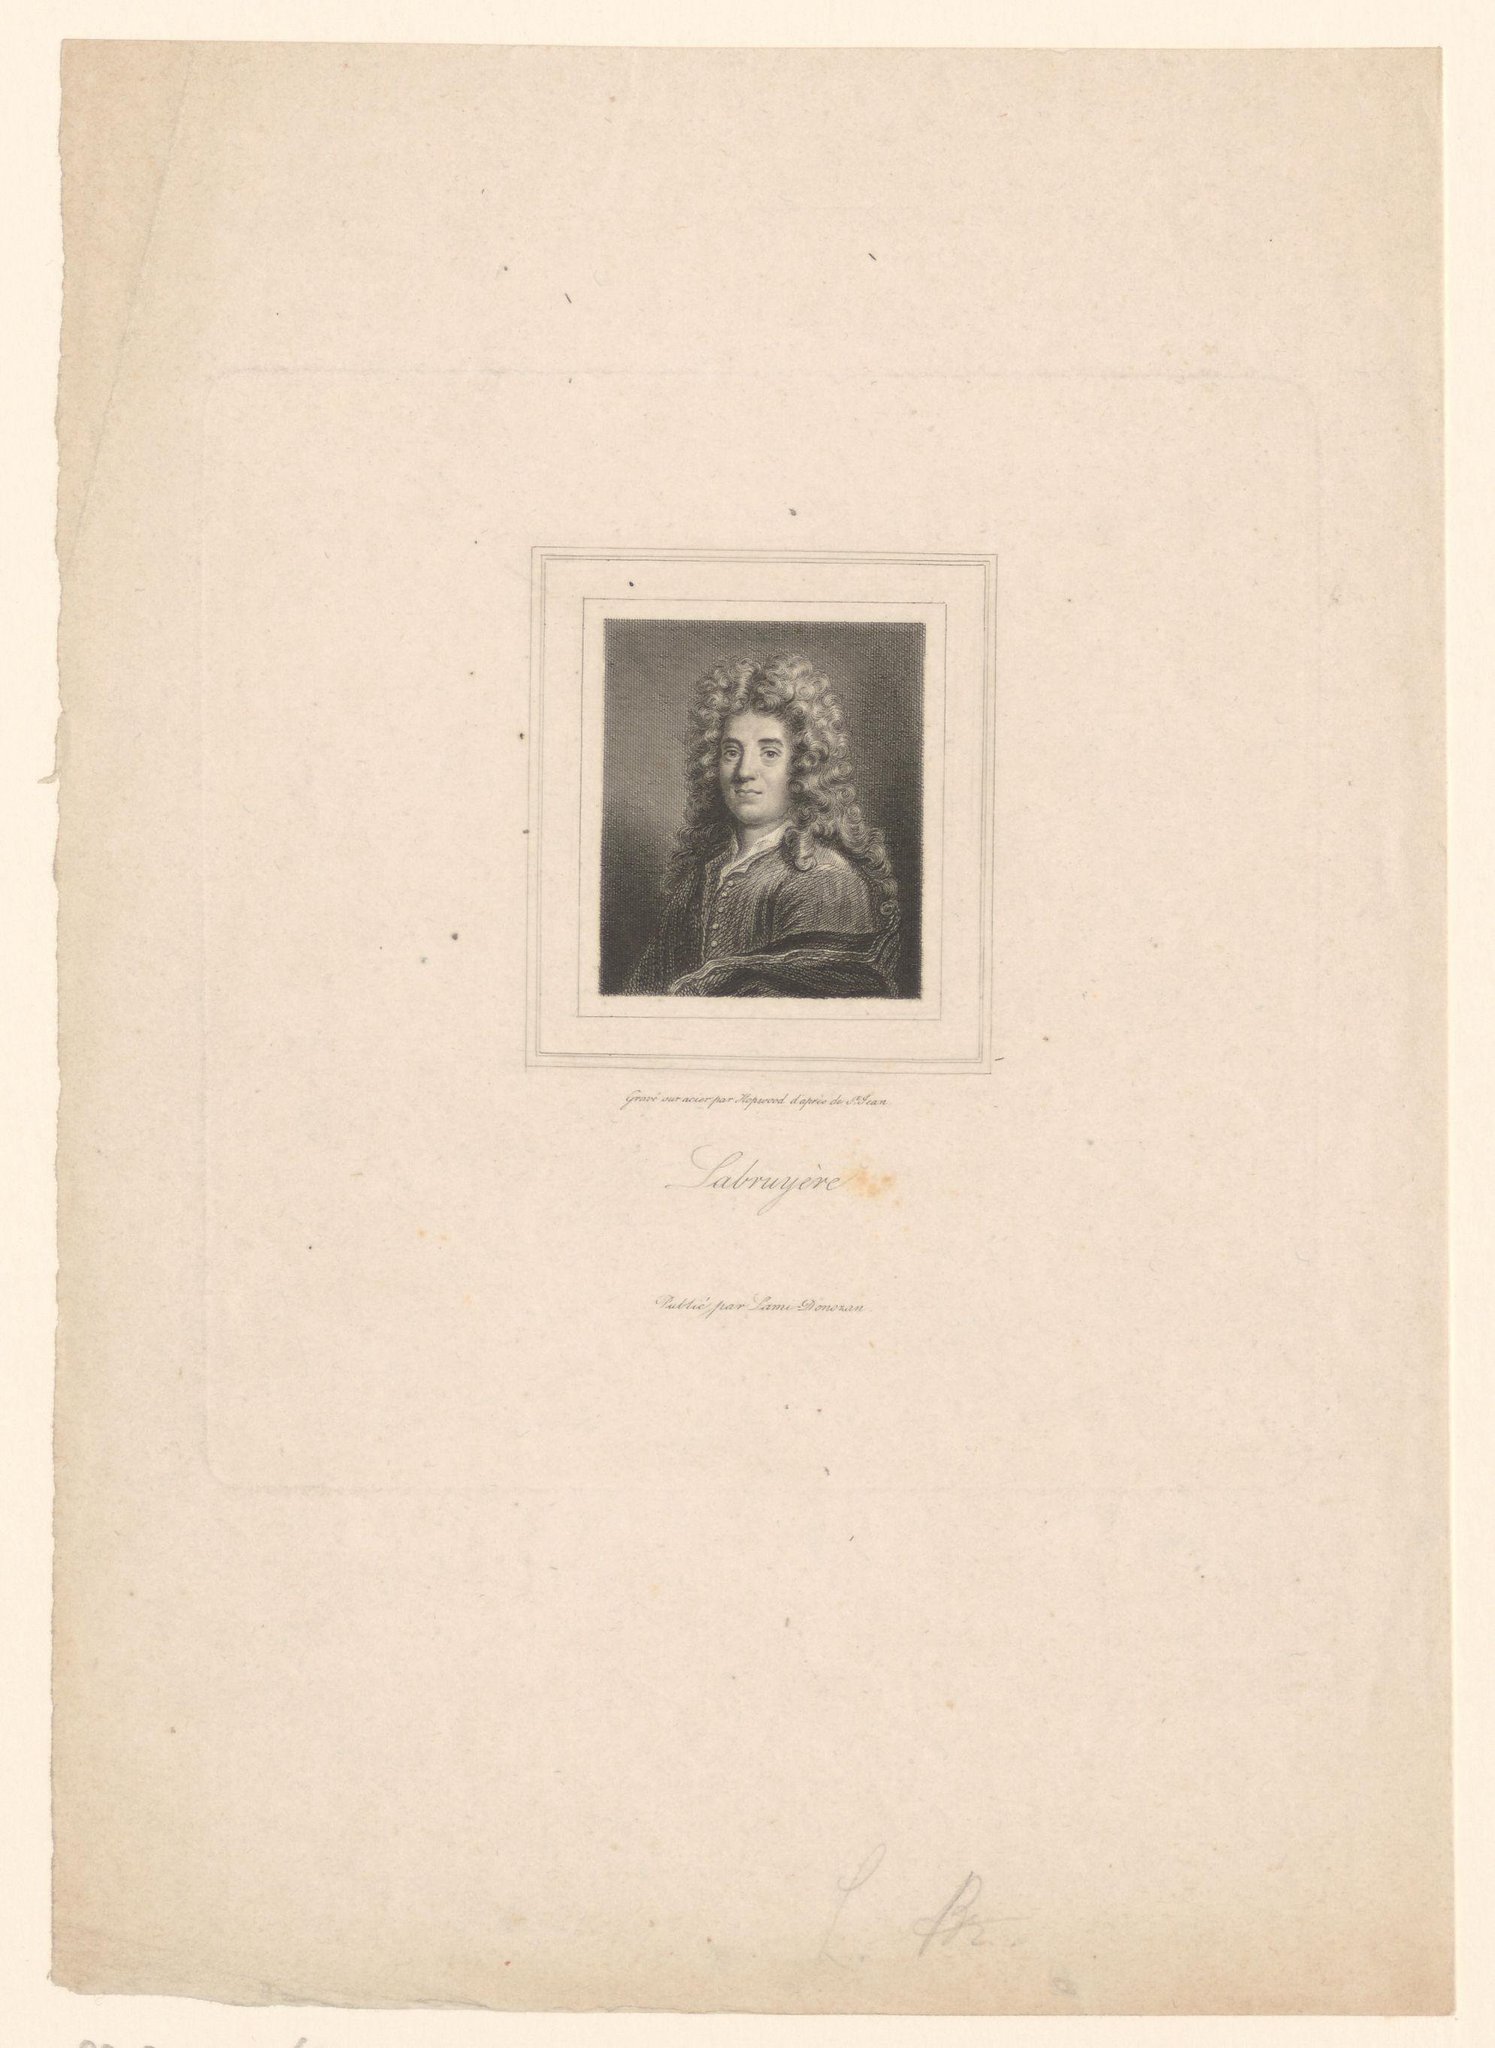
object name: print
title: Portret van Jean de La Bruyère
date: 1828-1850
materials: paper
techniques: etching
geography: paris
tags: paris, historical persons, portrait of a writer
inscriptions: collector's mark: Lugt 2228